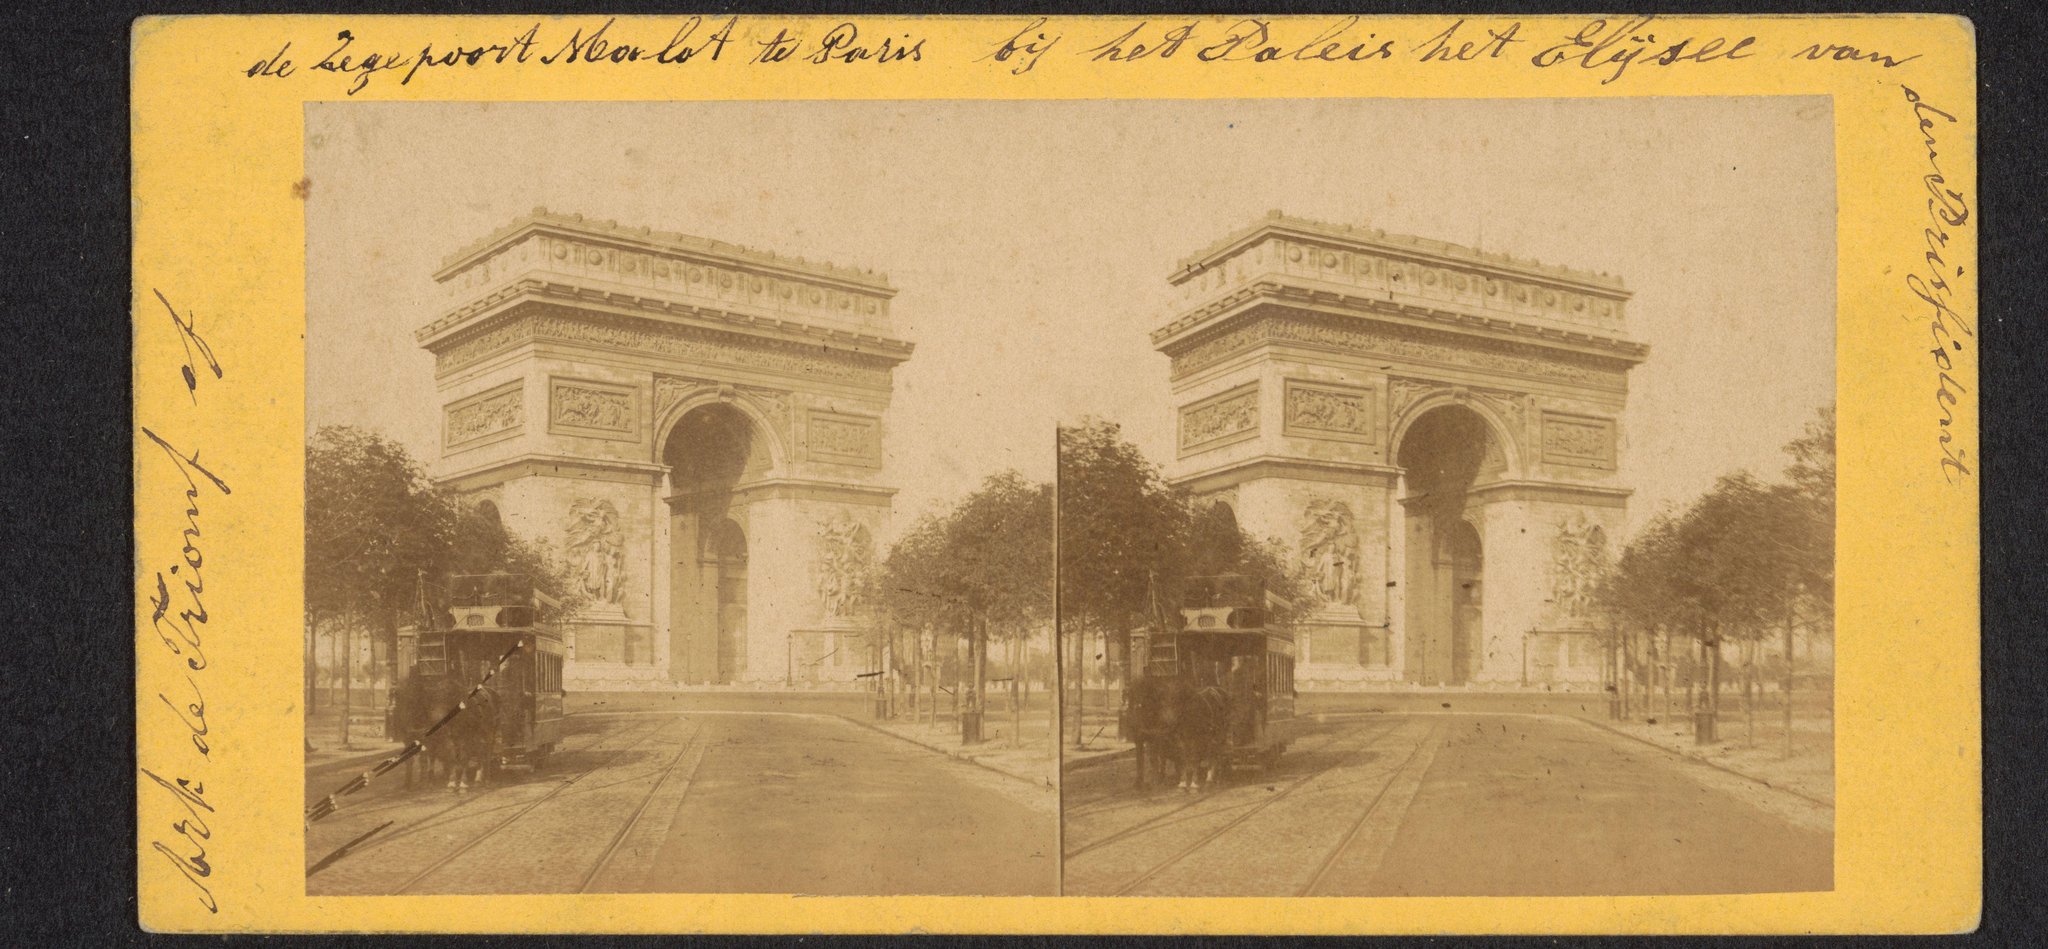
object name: stereograph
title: Gezicht op de Arc de Triomphe in Parijs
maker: Anonymous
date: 1850-1880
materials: cardboard, photographic support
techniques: albumen print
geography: paris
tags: triumphal arch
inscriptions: inscription: ‘Arc de l'Étoile Paris (...) deze straat is 1/2 uur lang en 200 meter breed’, inscription: ‘Arc de Triomf of de Zegepoort Morlot te Paris bij het Paleis het Elysee van den President’